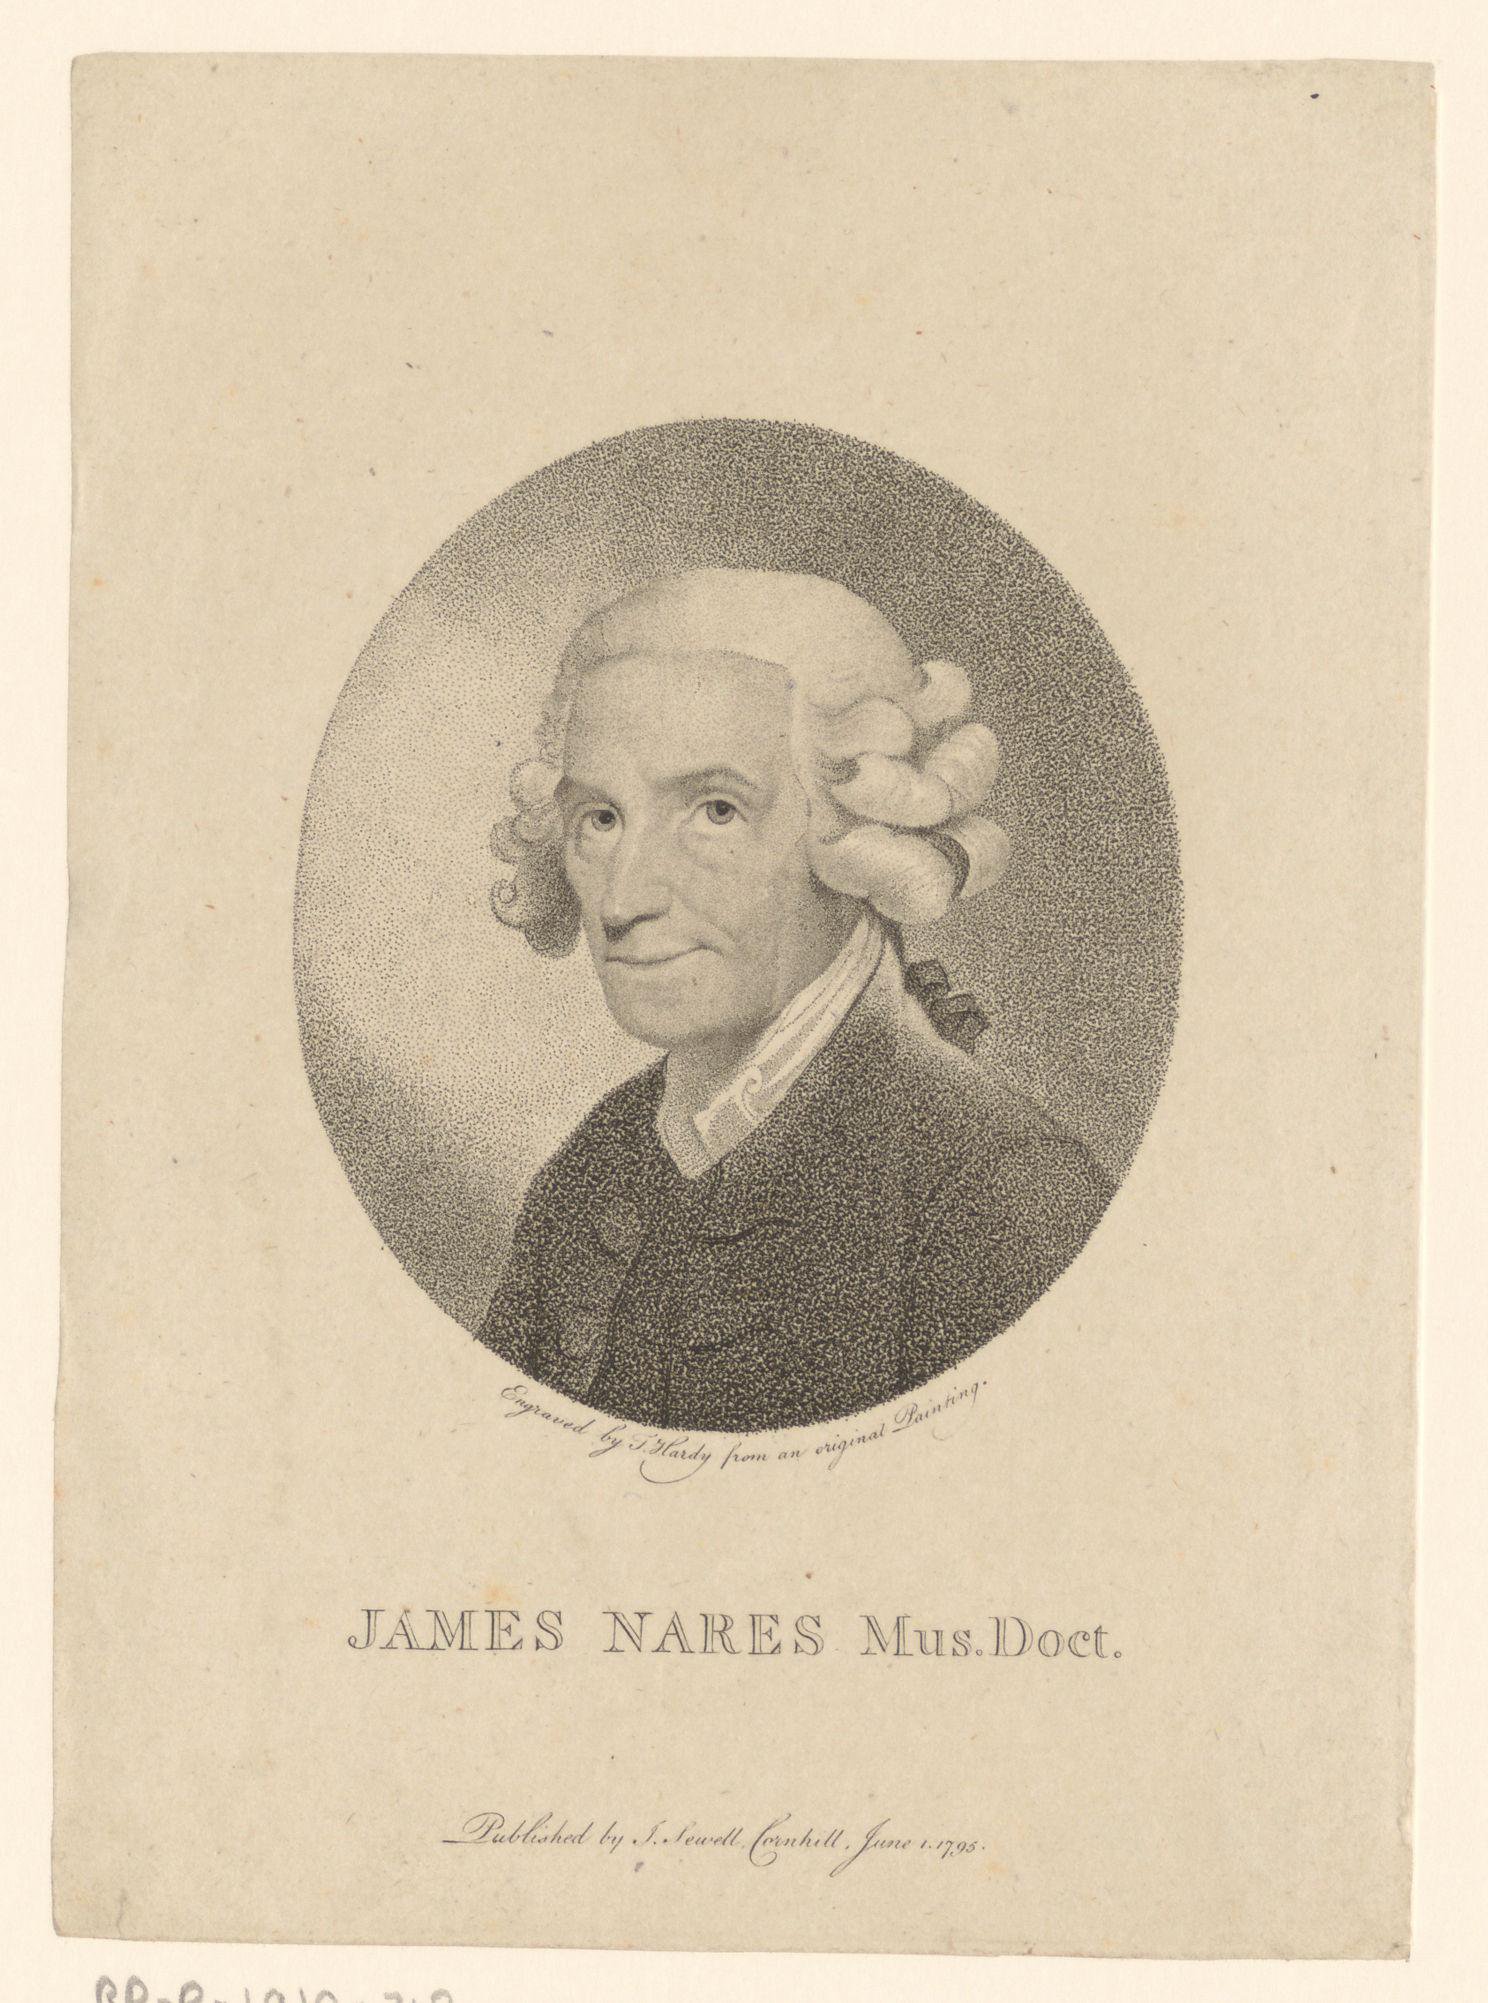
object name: print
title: James Nares Mus. Doct.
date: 1795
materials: paper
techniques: stippling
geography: great britain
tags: historical persons, portrait of composer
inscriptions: collector's mark: Lugt 2228